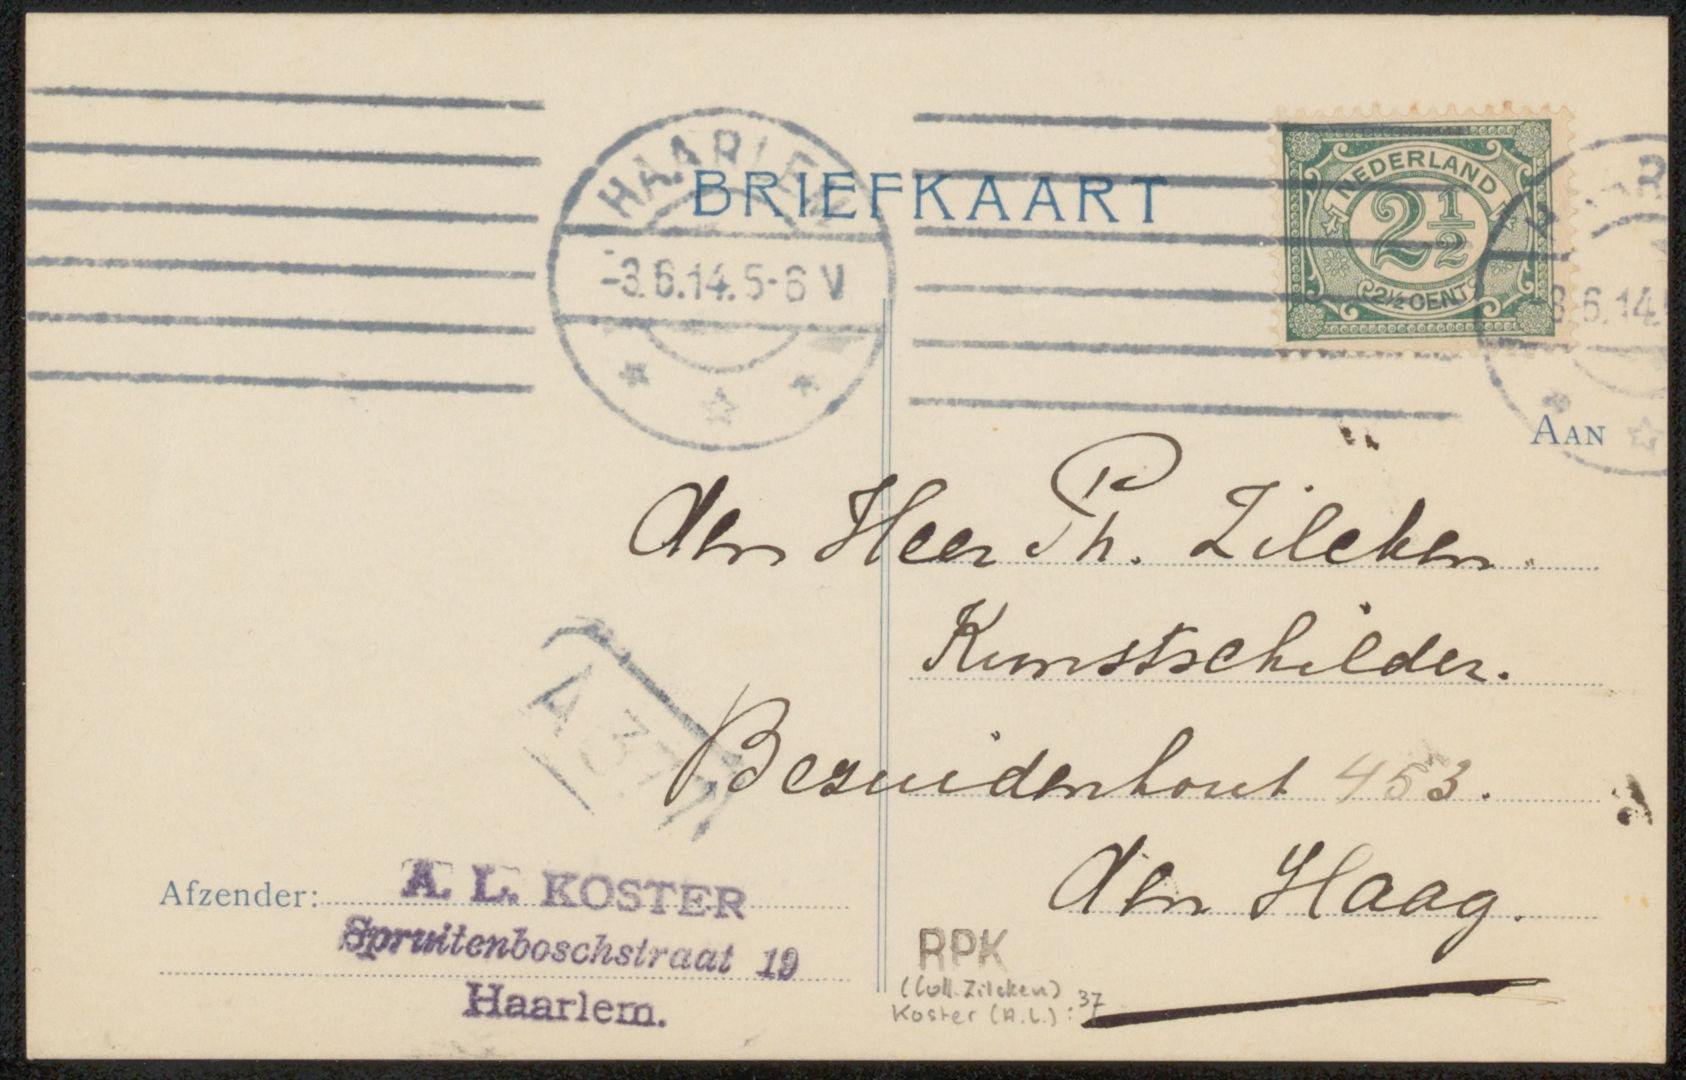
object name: postcard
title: Briefkaart aan Philip Zilcken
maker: anton l. koster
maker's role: draughtsman, painter, print maker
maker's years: 1859-1937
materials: cardboard, ink, pencil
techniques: pen, writing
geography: haarlem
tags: draughtsman, philip zilcken, the hague, venice, copenhagen (city)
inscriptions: address: ‘A.L. KOSTER/ Spruitenboschstraat 19/ Haarlem.’, collector's mark: ‘RPK’